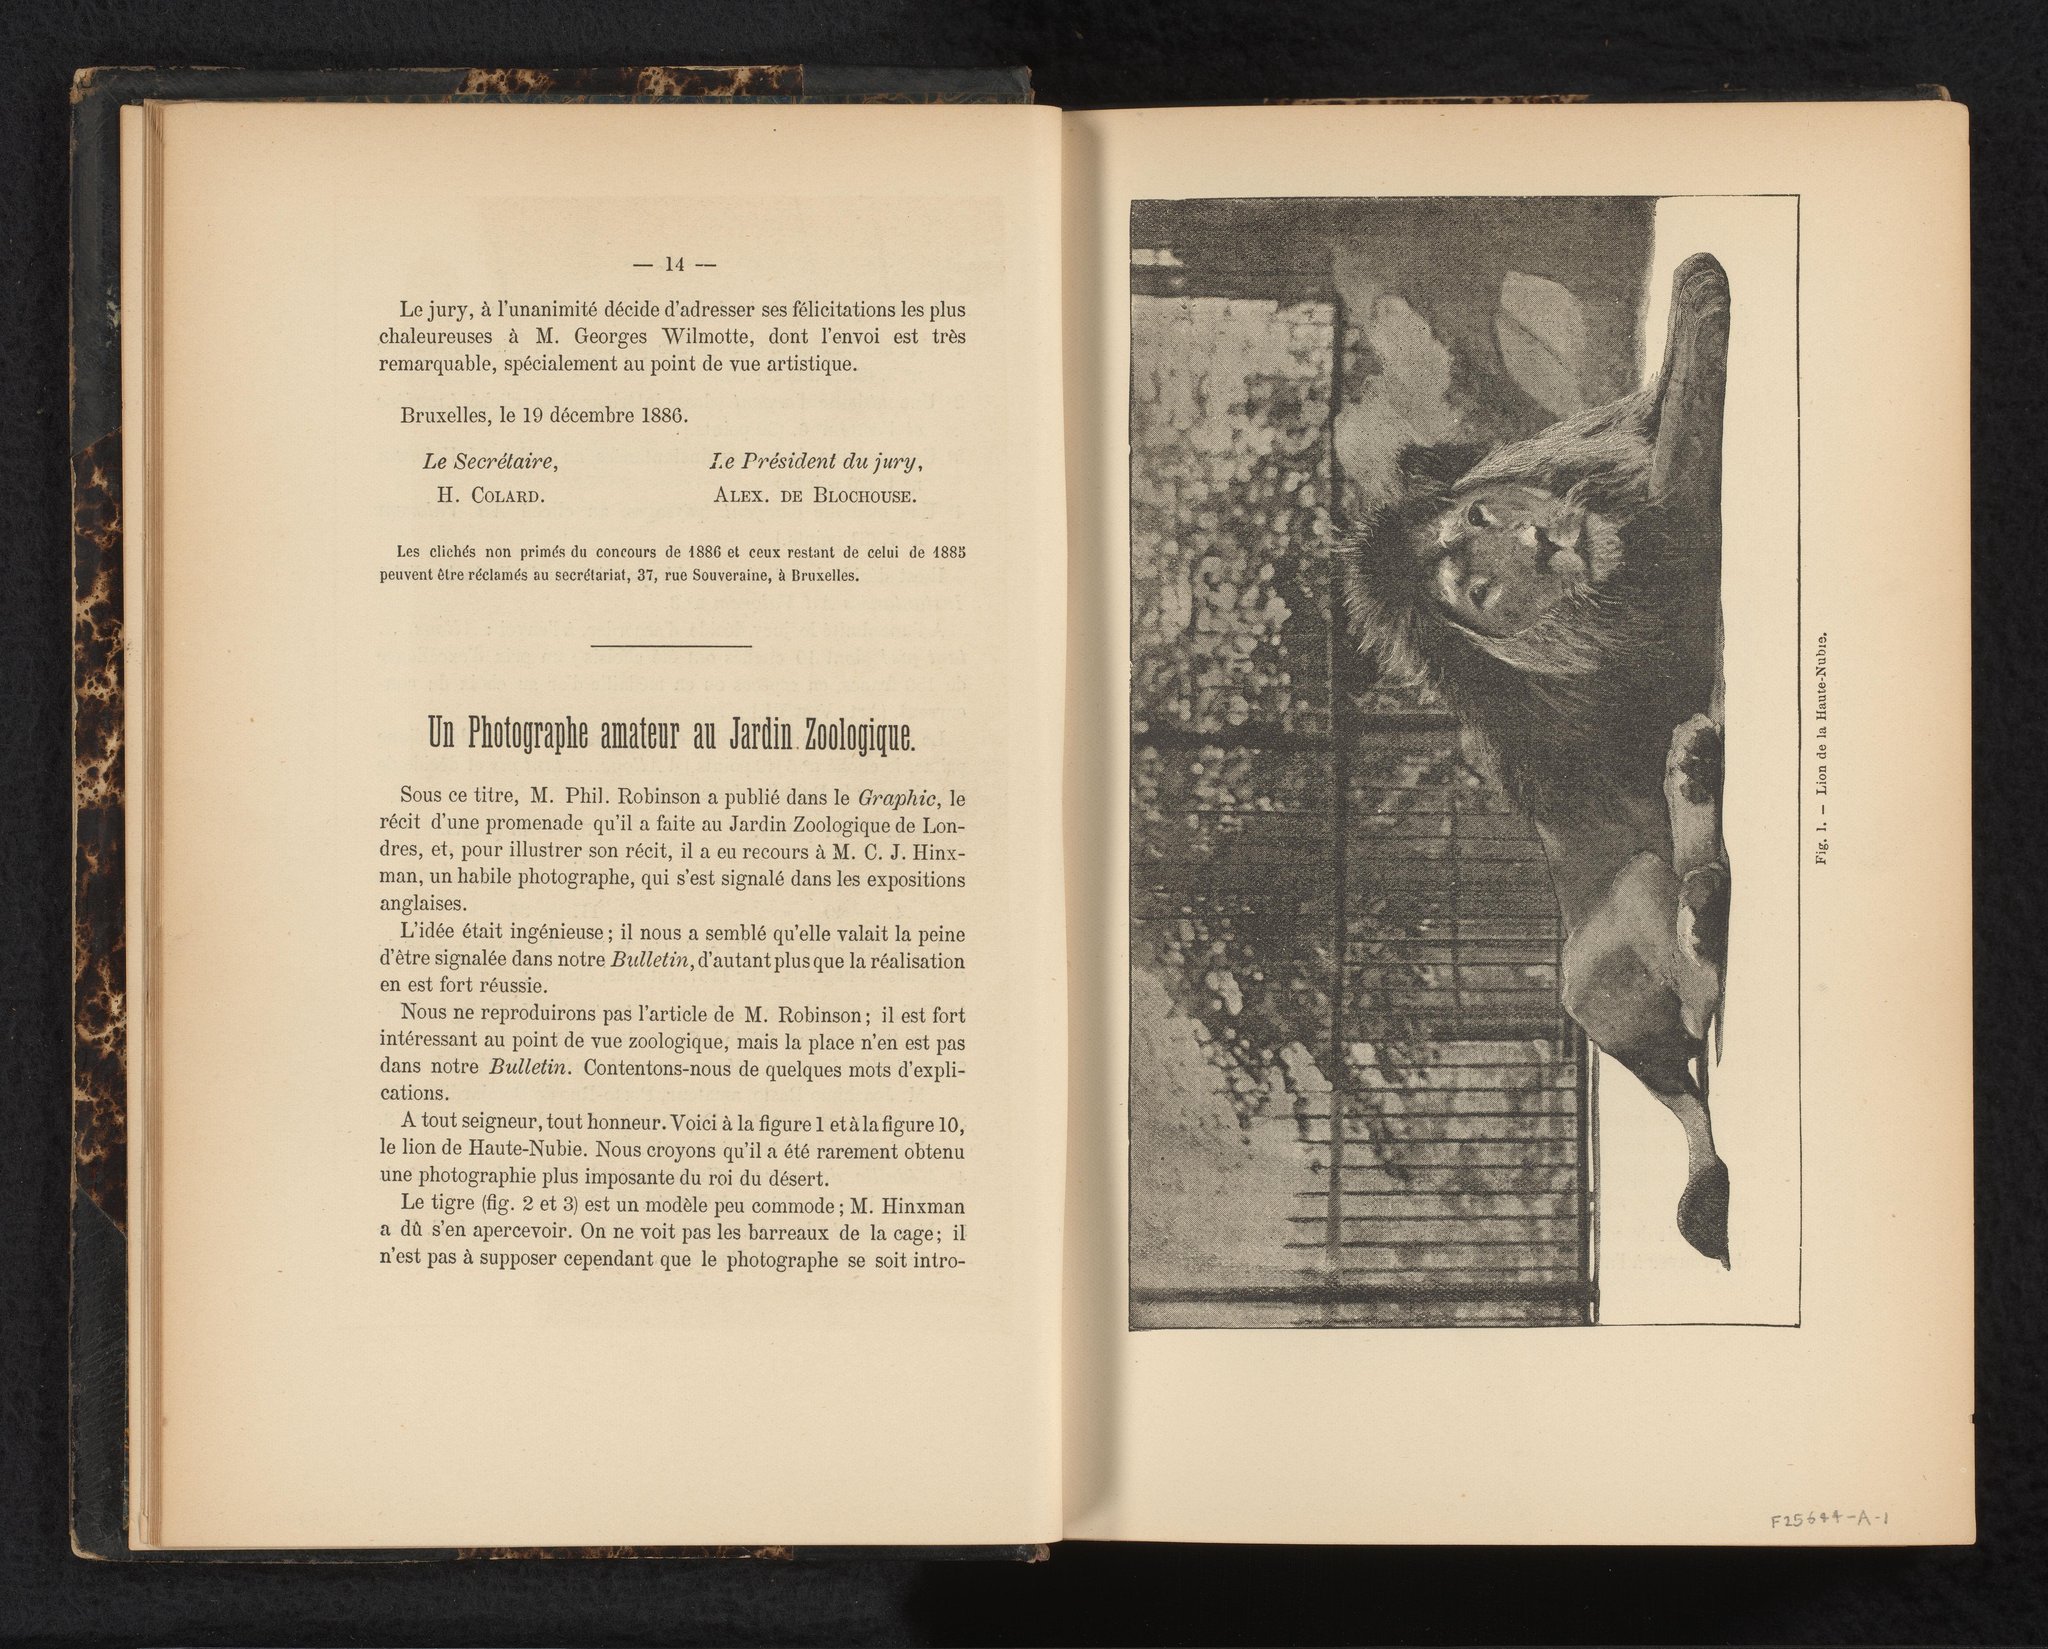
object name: page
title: Lion de la Haute-Nubie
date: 1882-1887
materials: paper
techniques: autotype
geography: london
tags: beasts of prey, predatory animals: lion